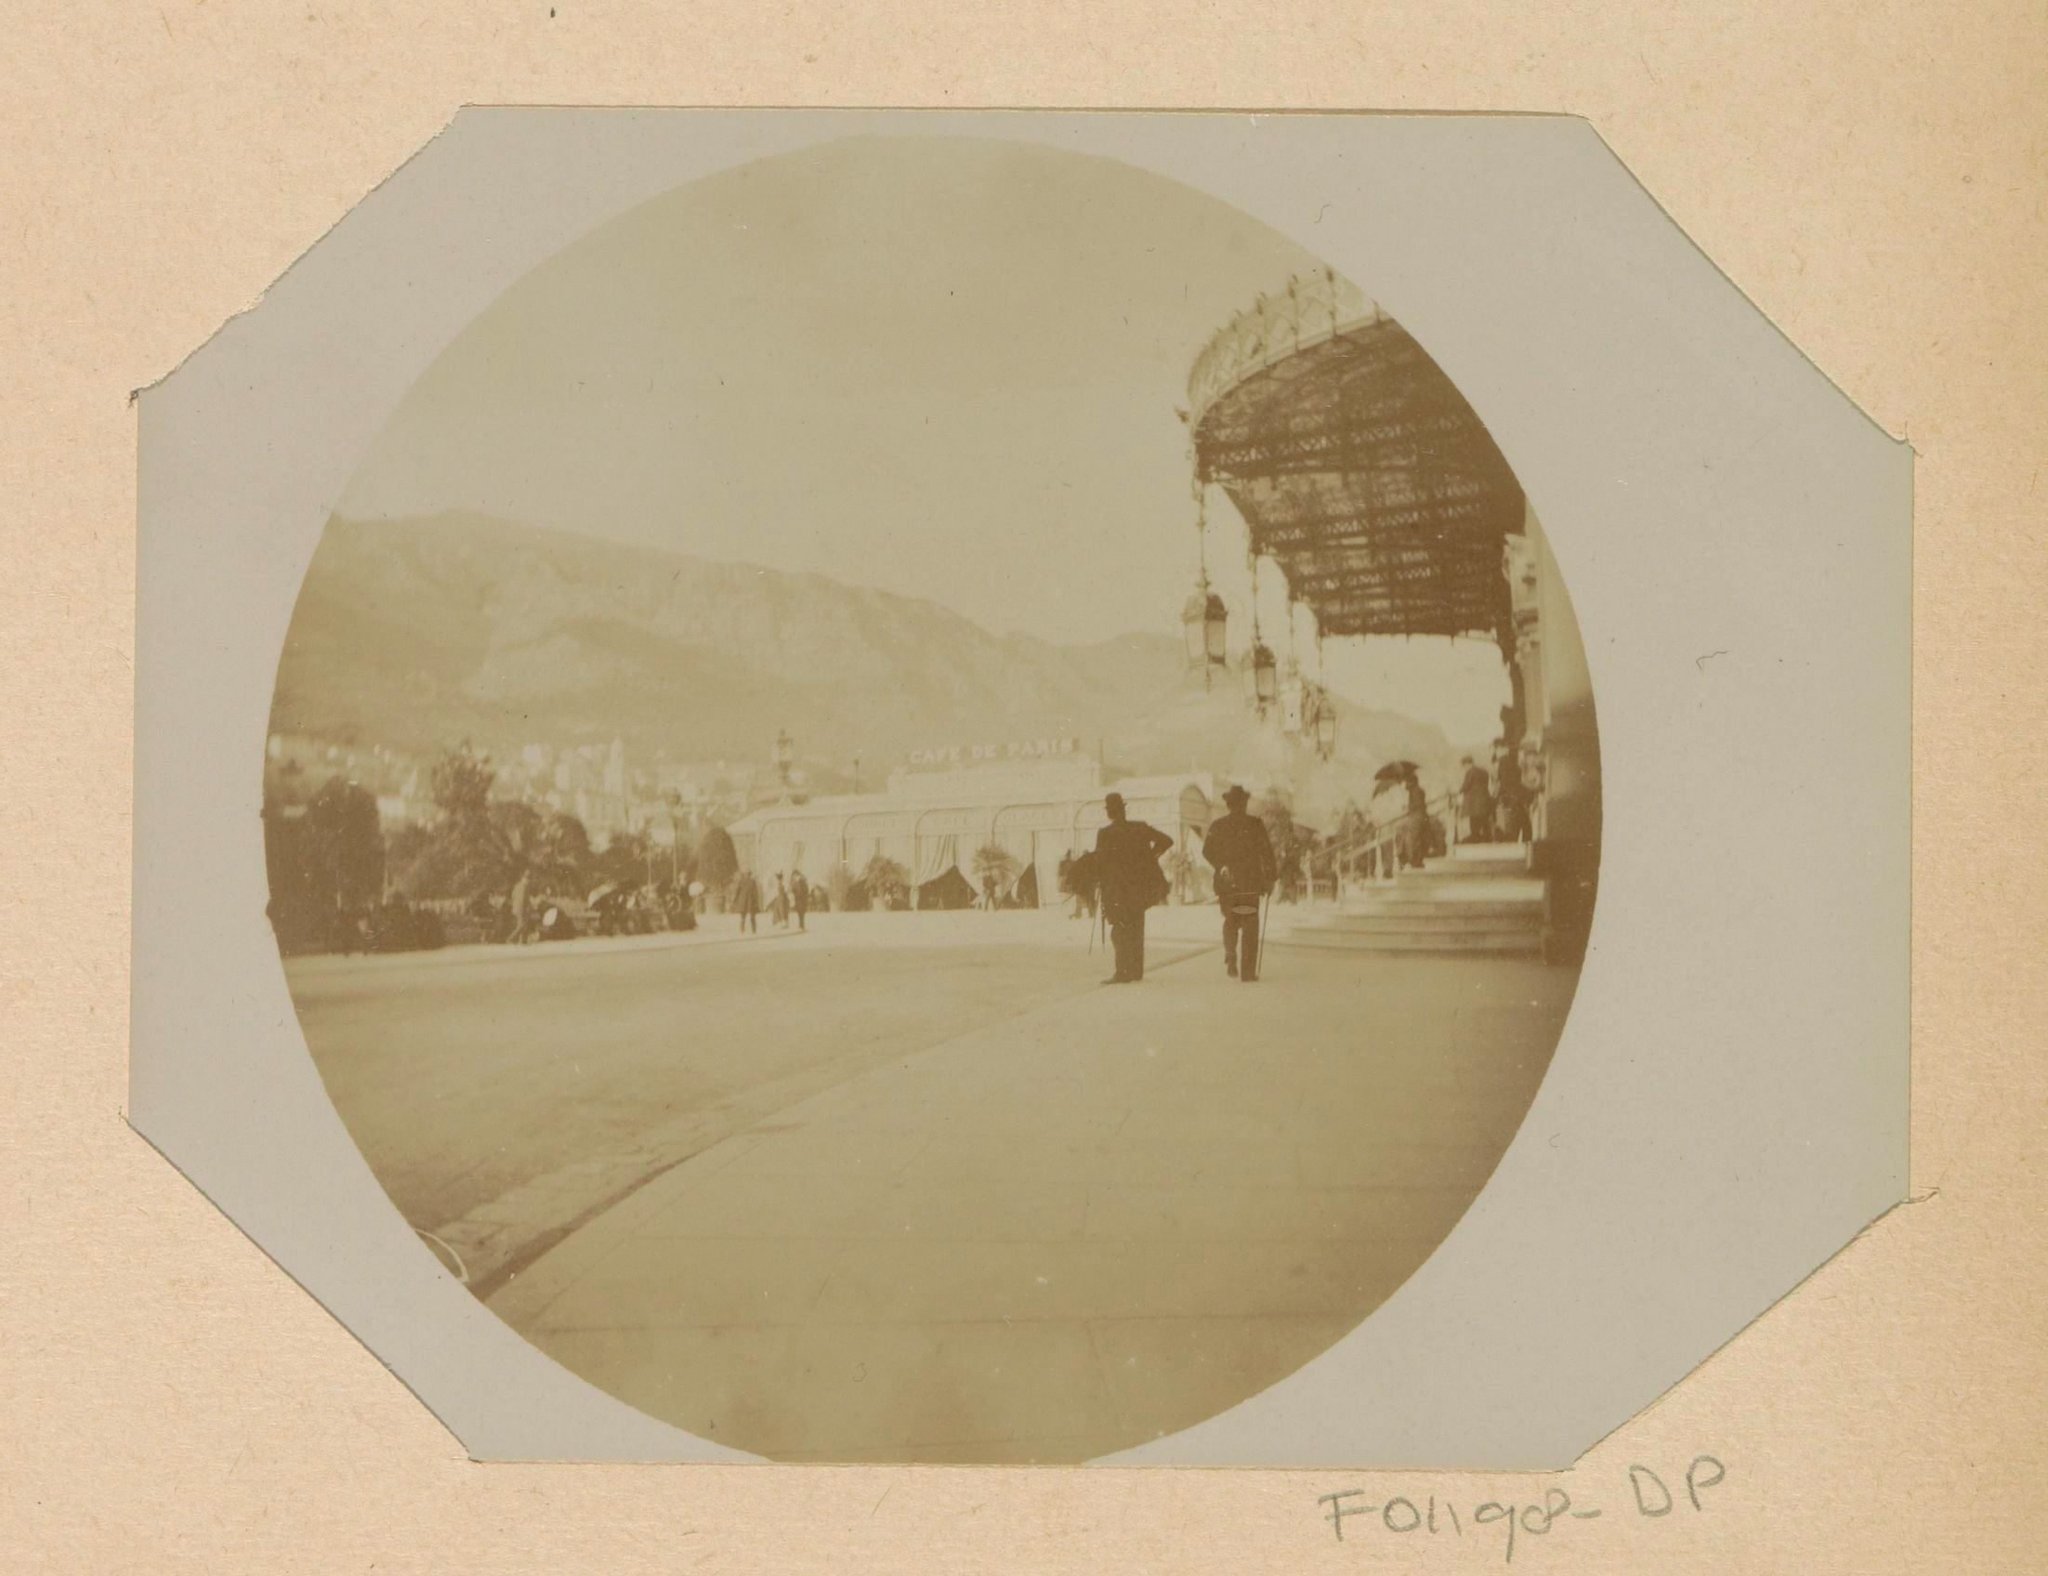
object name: album leaf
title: Straatgezicht met Café de Paris in Monte Carlo, rechts de luifel van het Monte Carlo Casino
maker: johanna margaretha piek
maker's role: fotograaf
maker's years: 1870-1947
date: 1889-1893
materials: paper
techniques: gelatin silver print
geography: monte carlo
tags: street